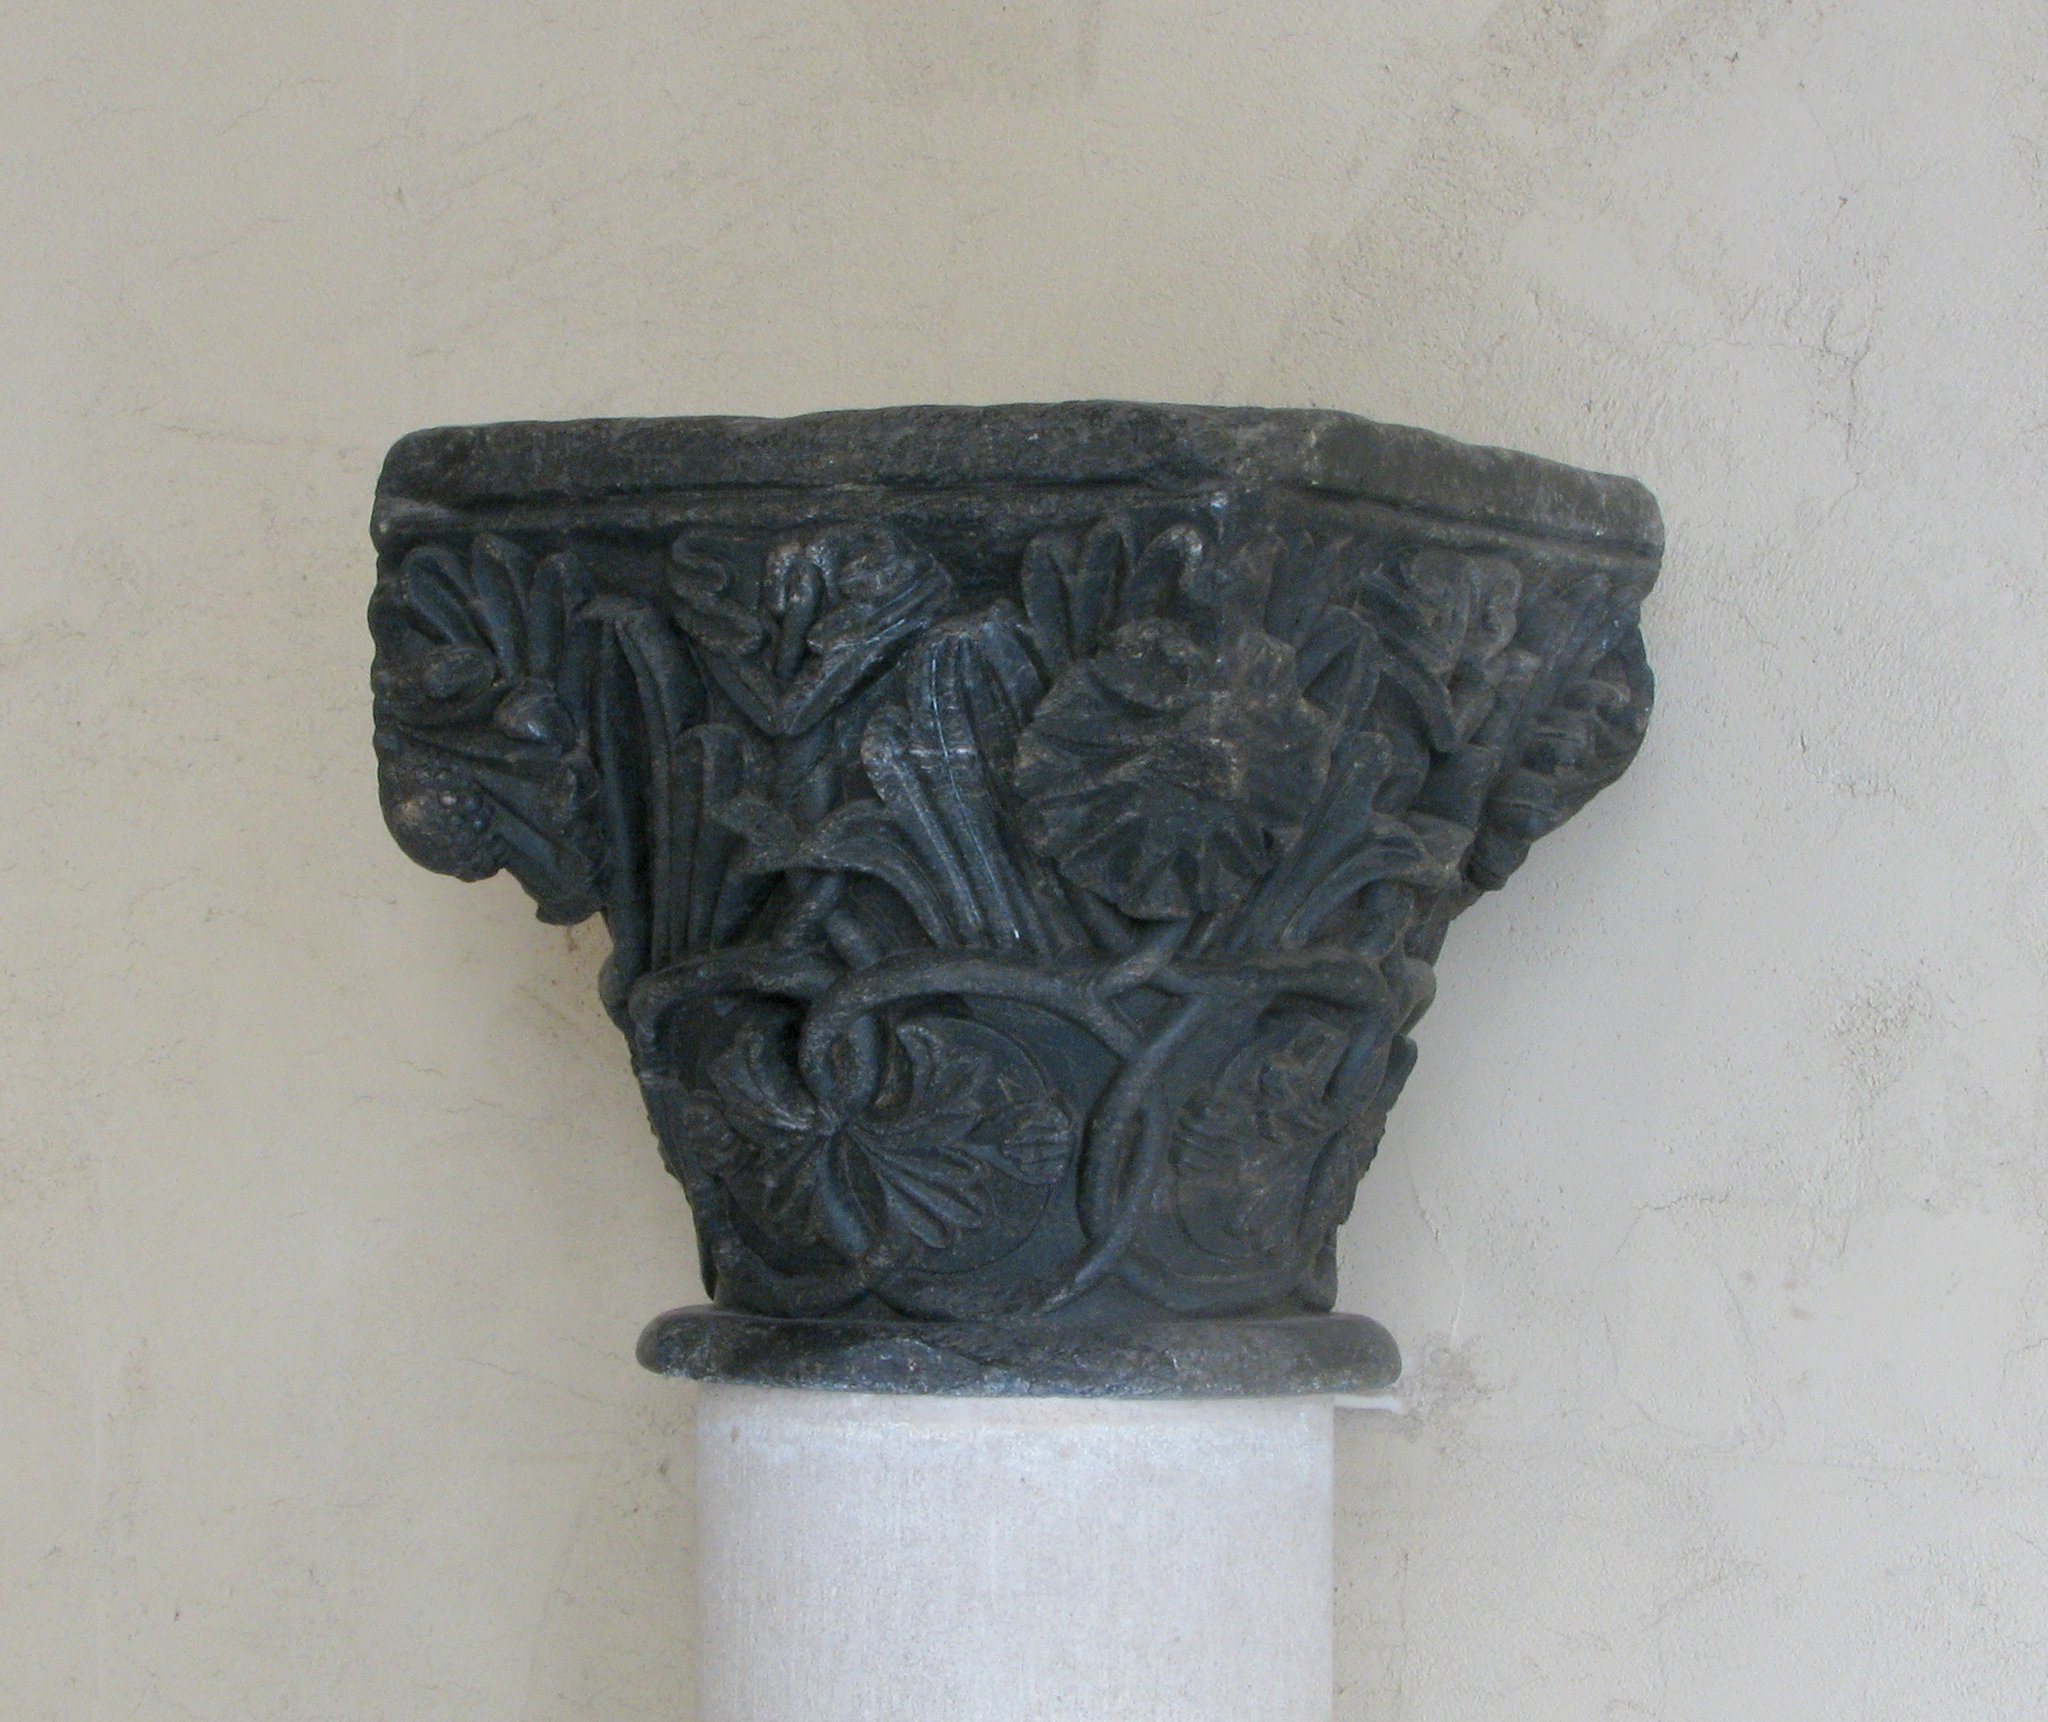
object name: capital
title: Foliate Capital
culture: french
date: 1101-1133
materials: marble